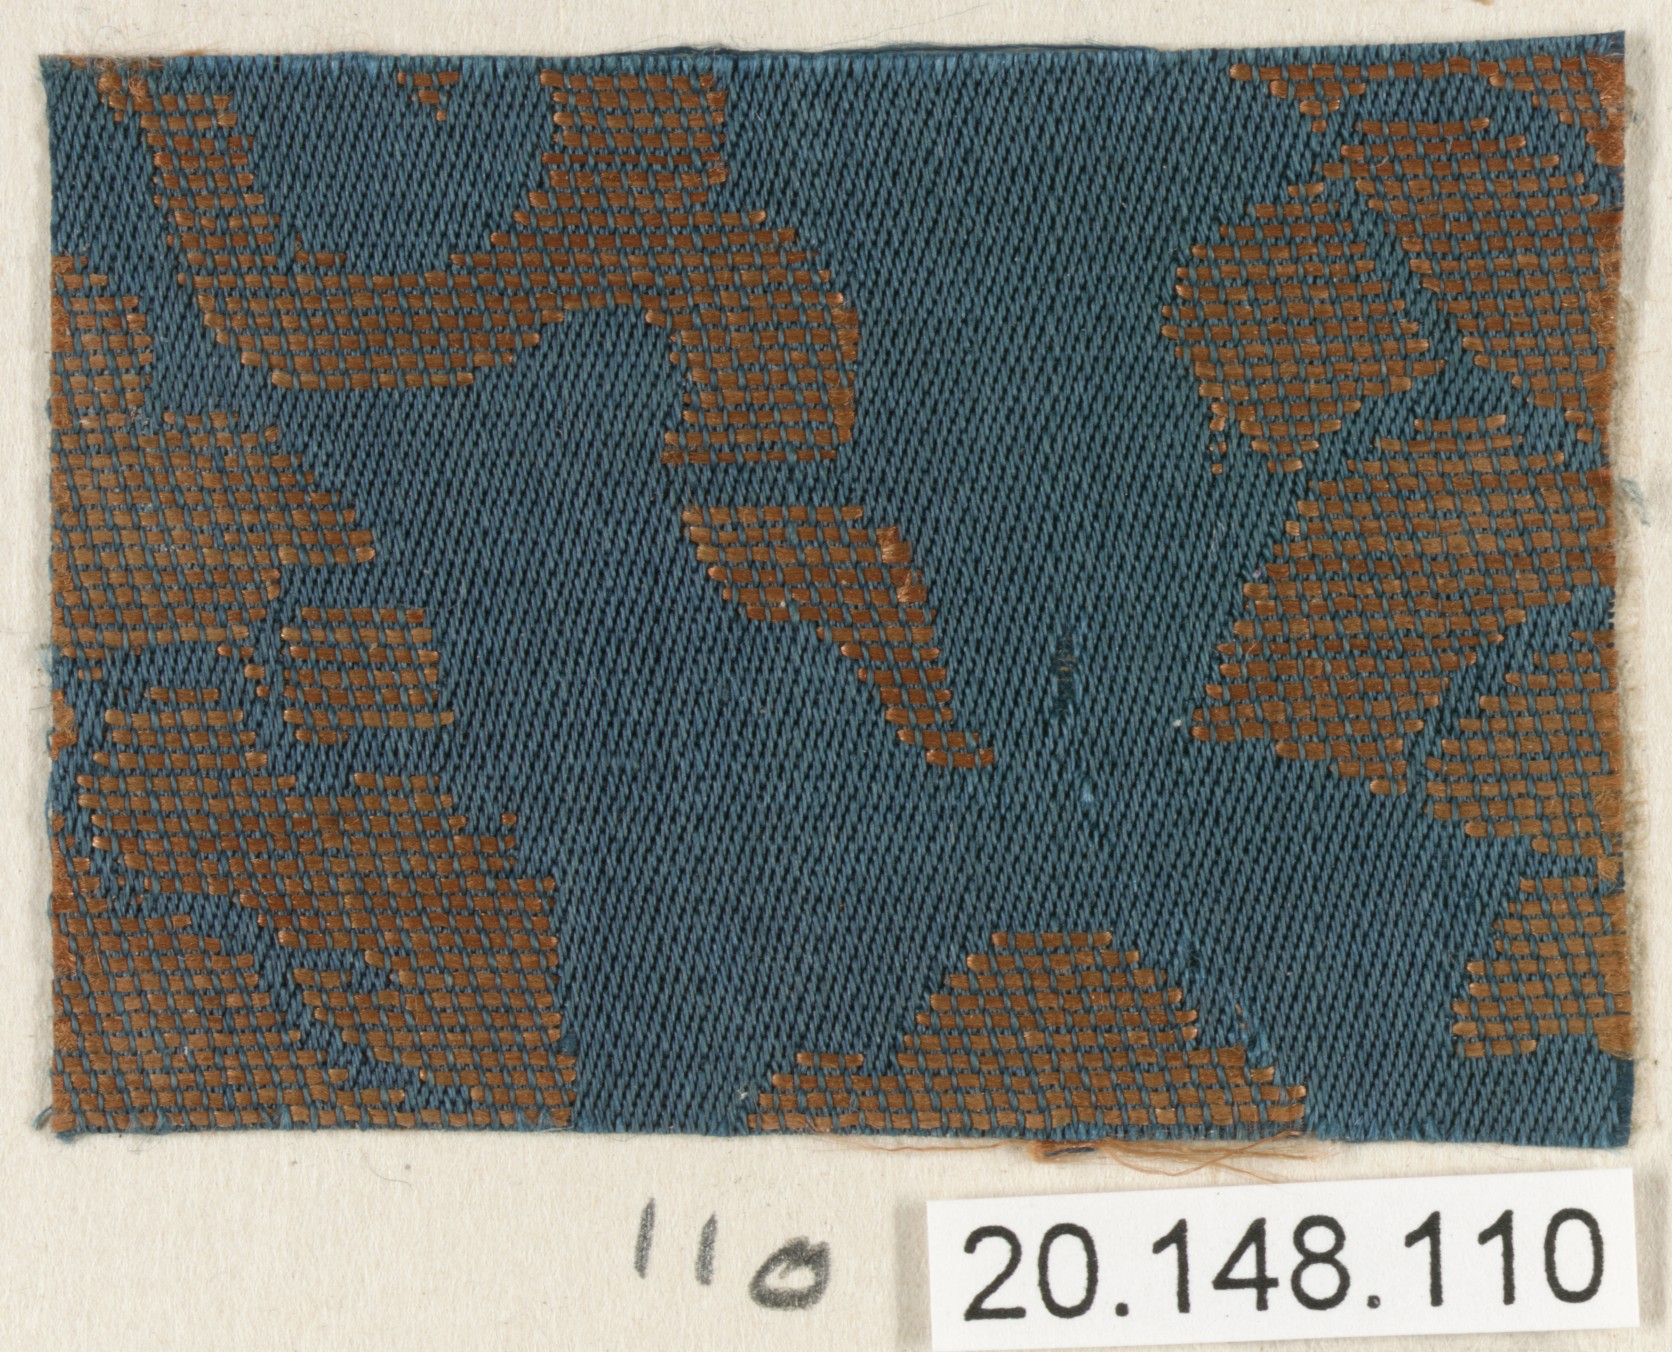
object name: piece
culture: japanese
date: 1601-1700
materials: silk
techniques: compound weave